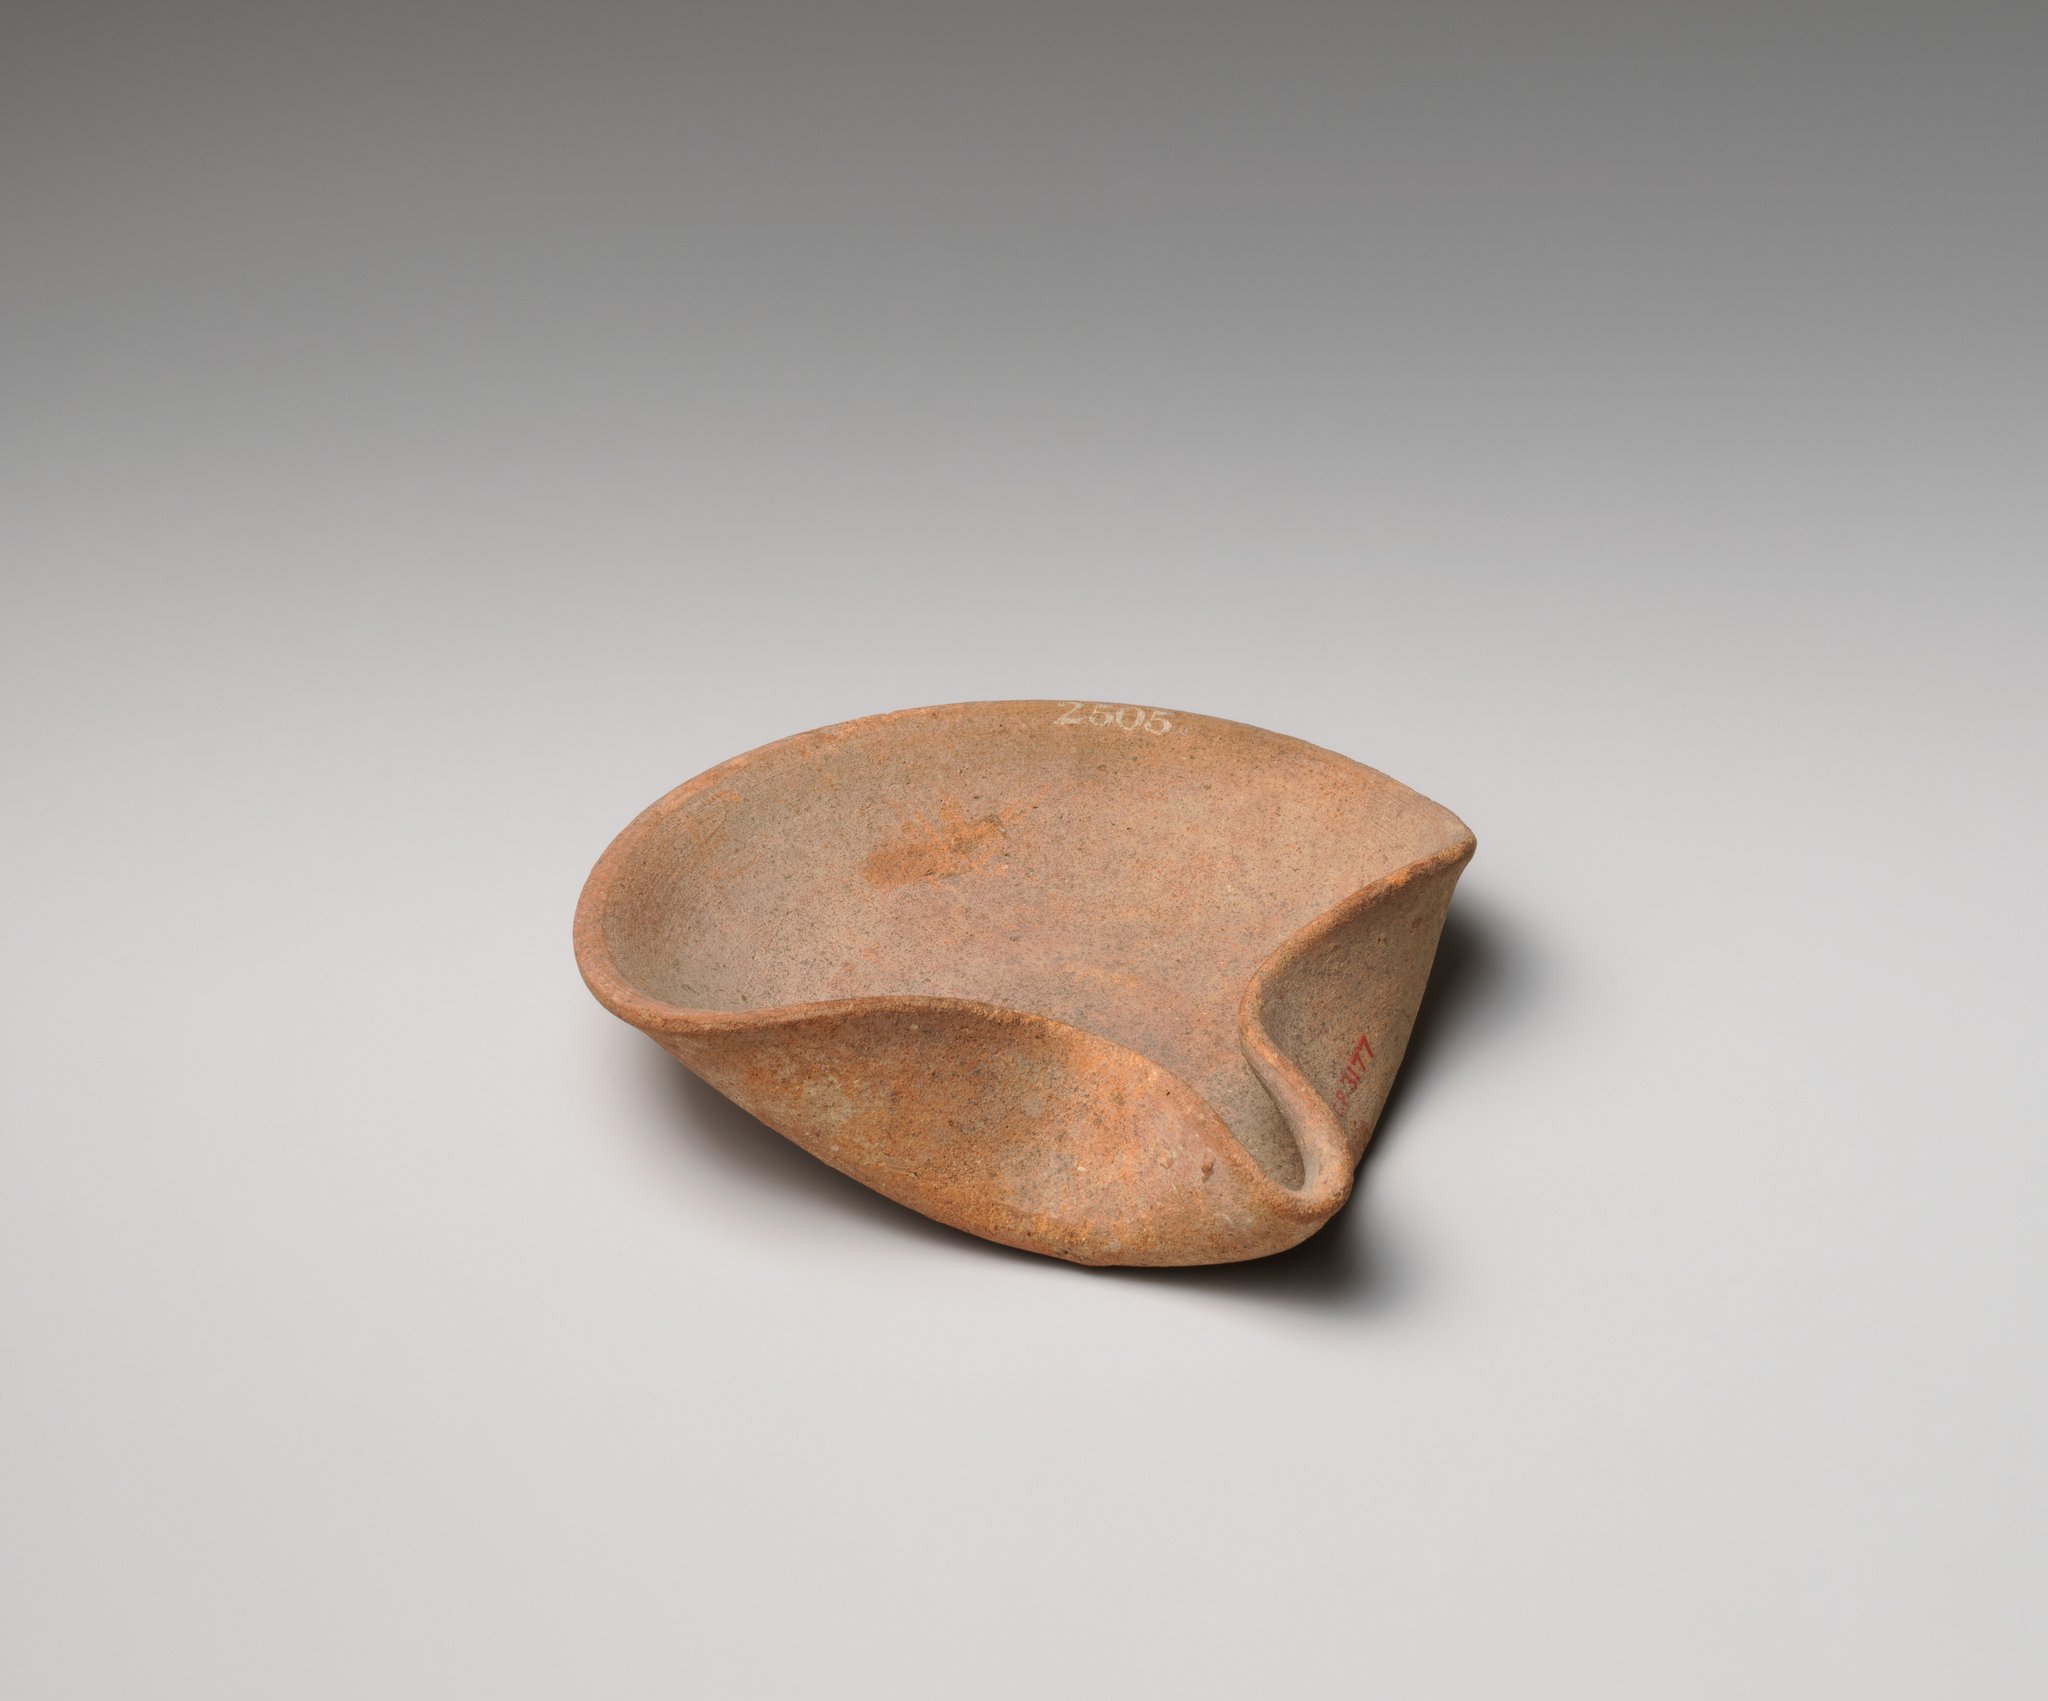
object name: lamp, saucer shaped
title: Terracotta saucer-shaped lamp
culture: cypriot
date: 400-301 BCE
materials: terracotta